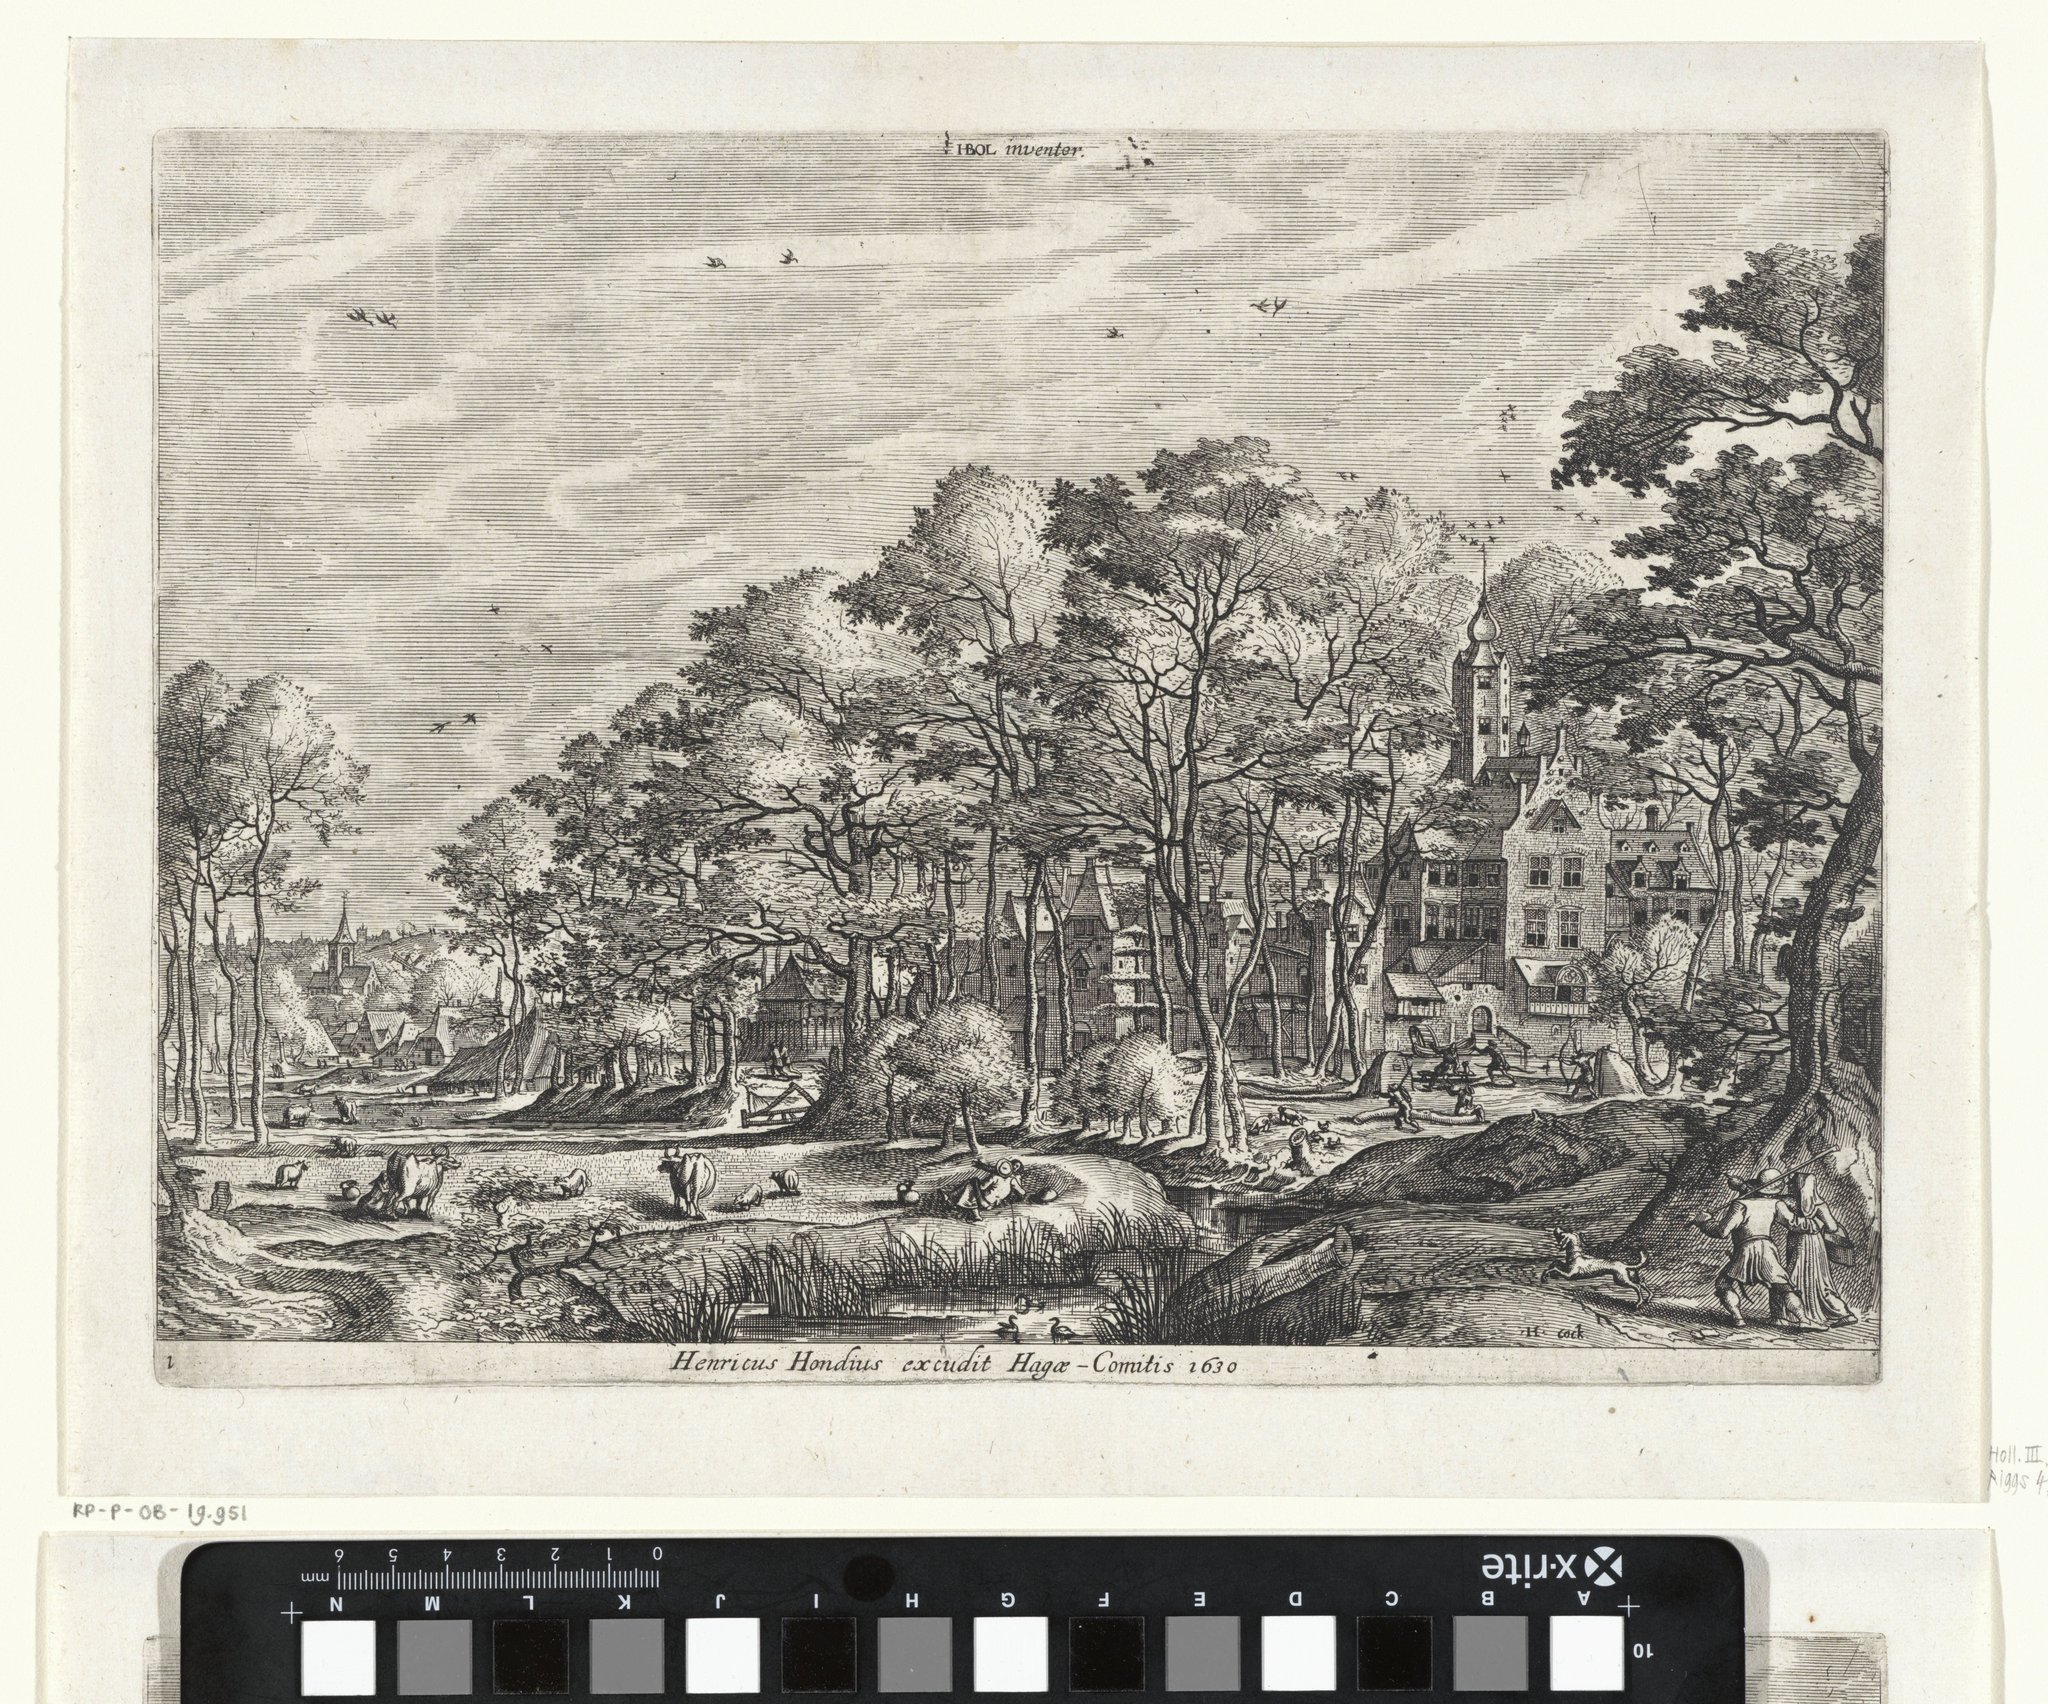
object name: print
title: Rivierlandschappen met bebouwing en figuren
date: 1630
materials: paper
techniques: etching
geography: the hague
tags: herding, herdsman, herdswoman, shepherd, shepherdess, cowherd, etc., hunter, brook (+ landscape with figures, staffage)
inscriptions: collector's mark: Lugt 2228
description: Links van de beek liggen twee herders in een weiland bij hun koeien en schapen. Rechts van de beek enkele jagers met honden. Rechtsvoor wandelt een paar met een hond. Op de achtergrond enkele gebouwen.